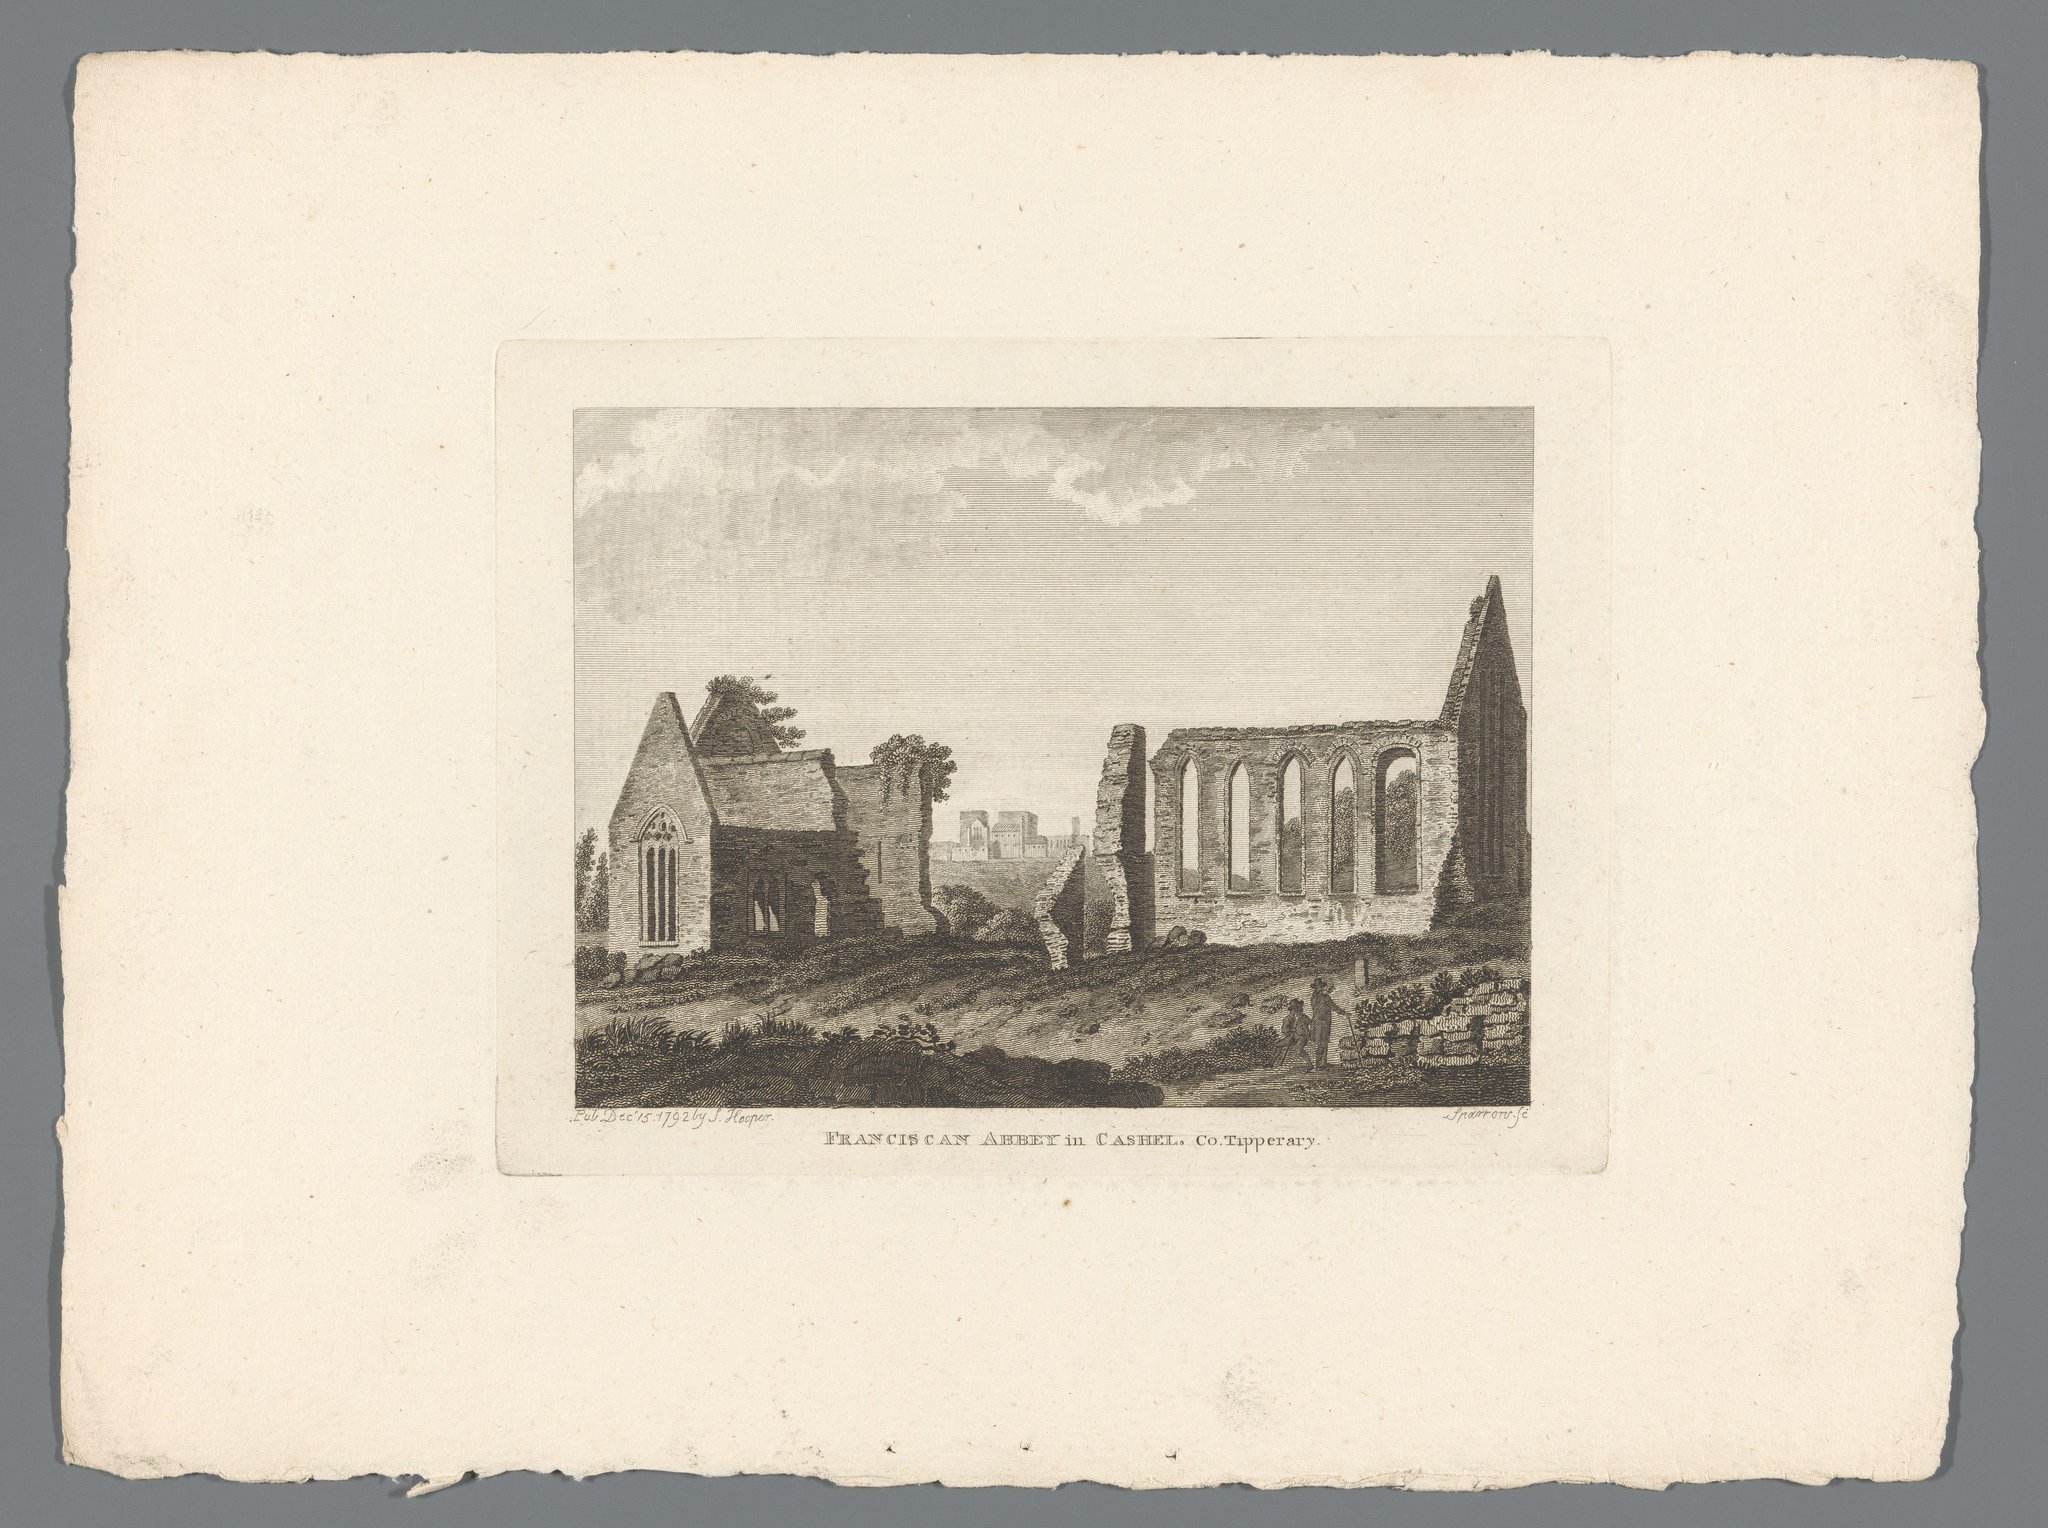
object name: book illustration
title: Oudheden in Ierland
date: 1792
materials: paper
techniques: etching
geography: london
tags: abbey, monastery, convent ~ roman catholic church, landscape with ruins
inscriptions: date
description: Prent verschenen in: Grose, Francis. Antiquities of Ireland. Londen: S. Hooper, 1809, dl. 2.